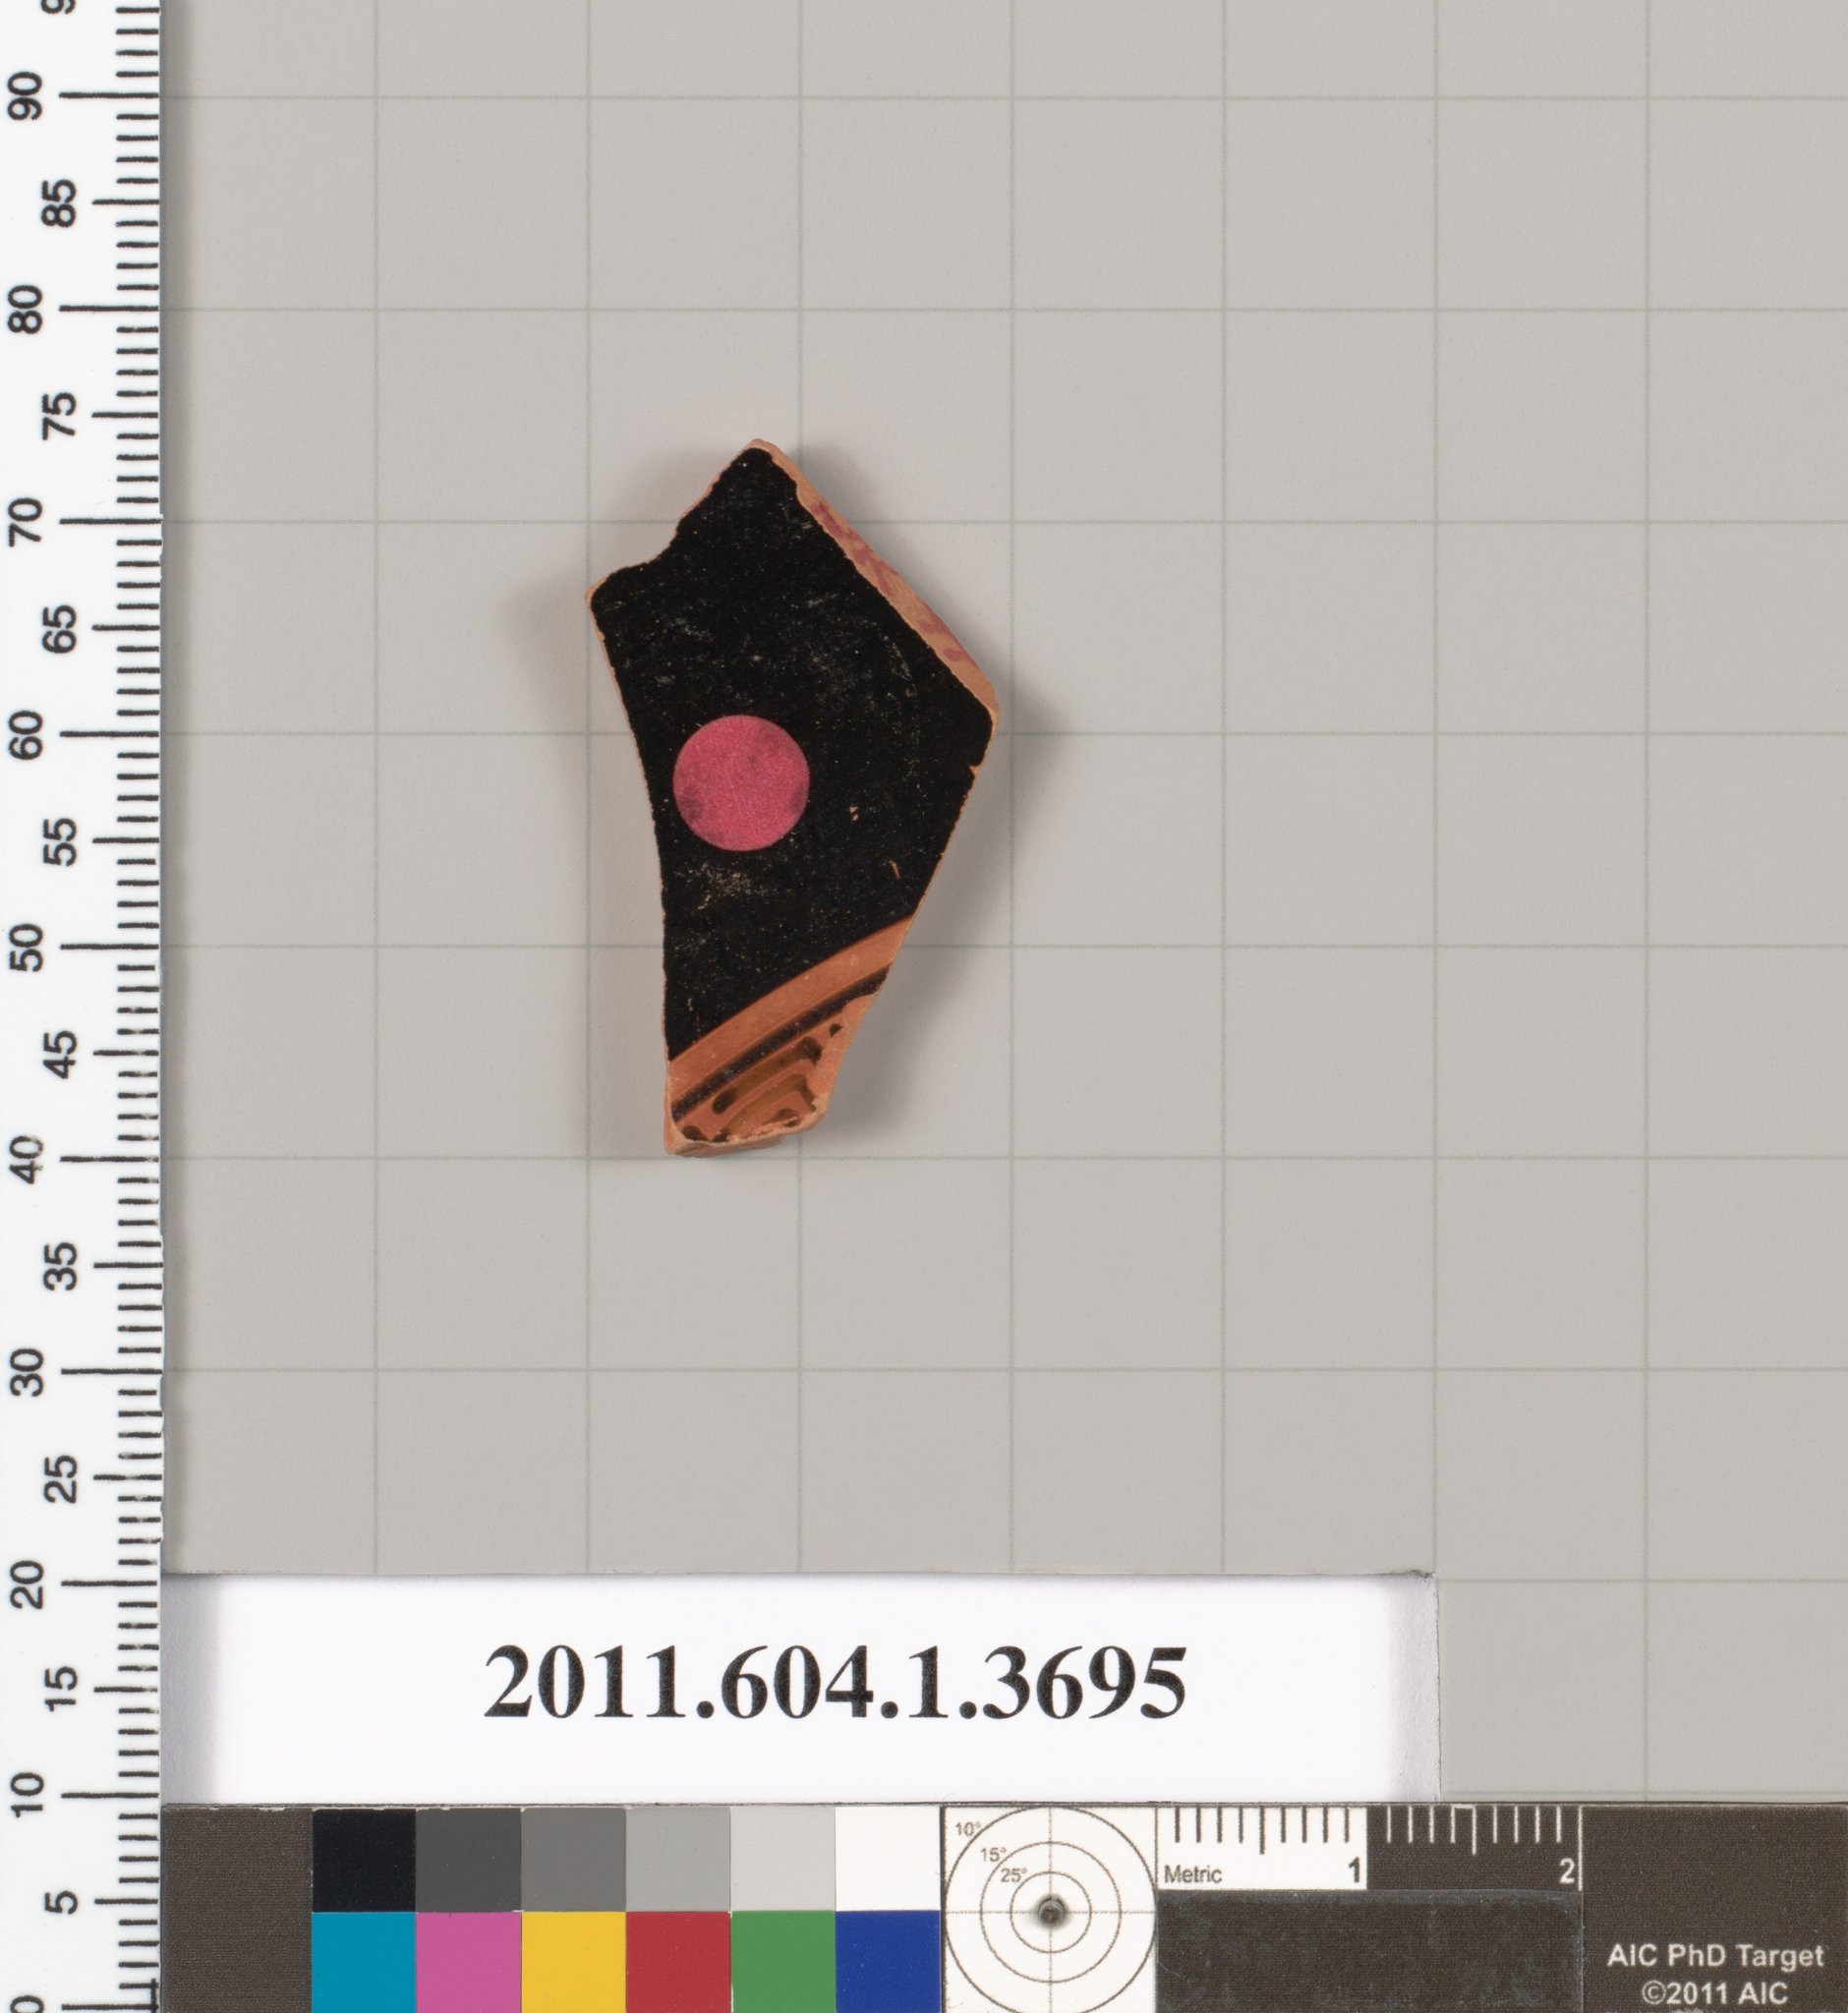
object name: kylix fragment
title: Terracotta fragment of a kylix (drinking cup)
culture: greek, attic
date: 475-451 BCE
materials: terracotta